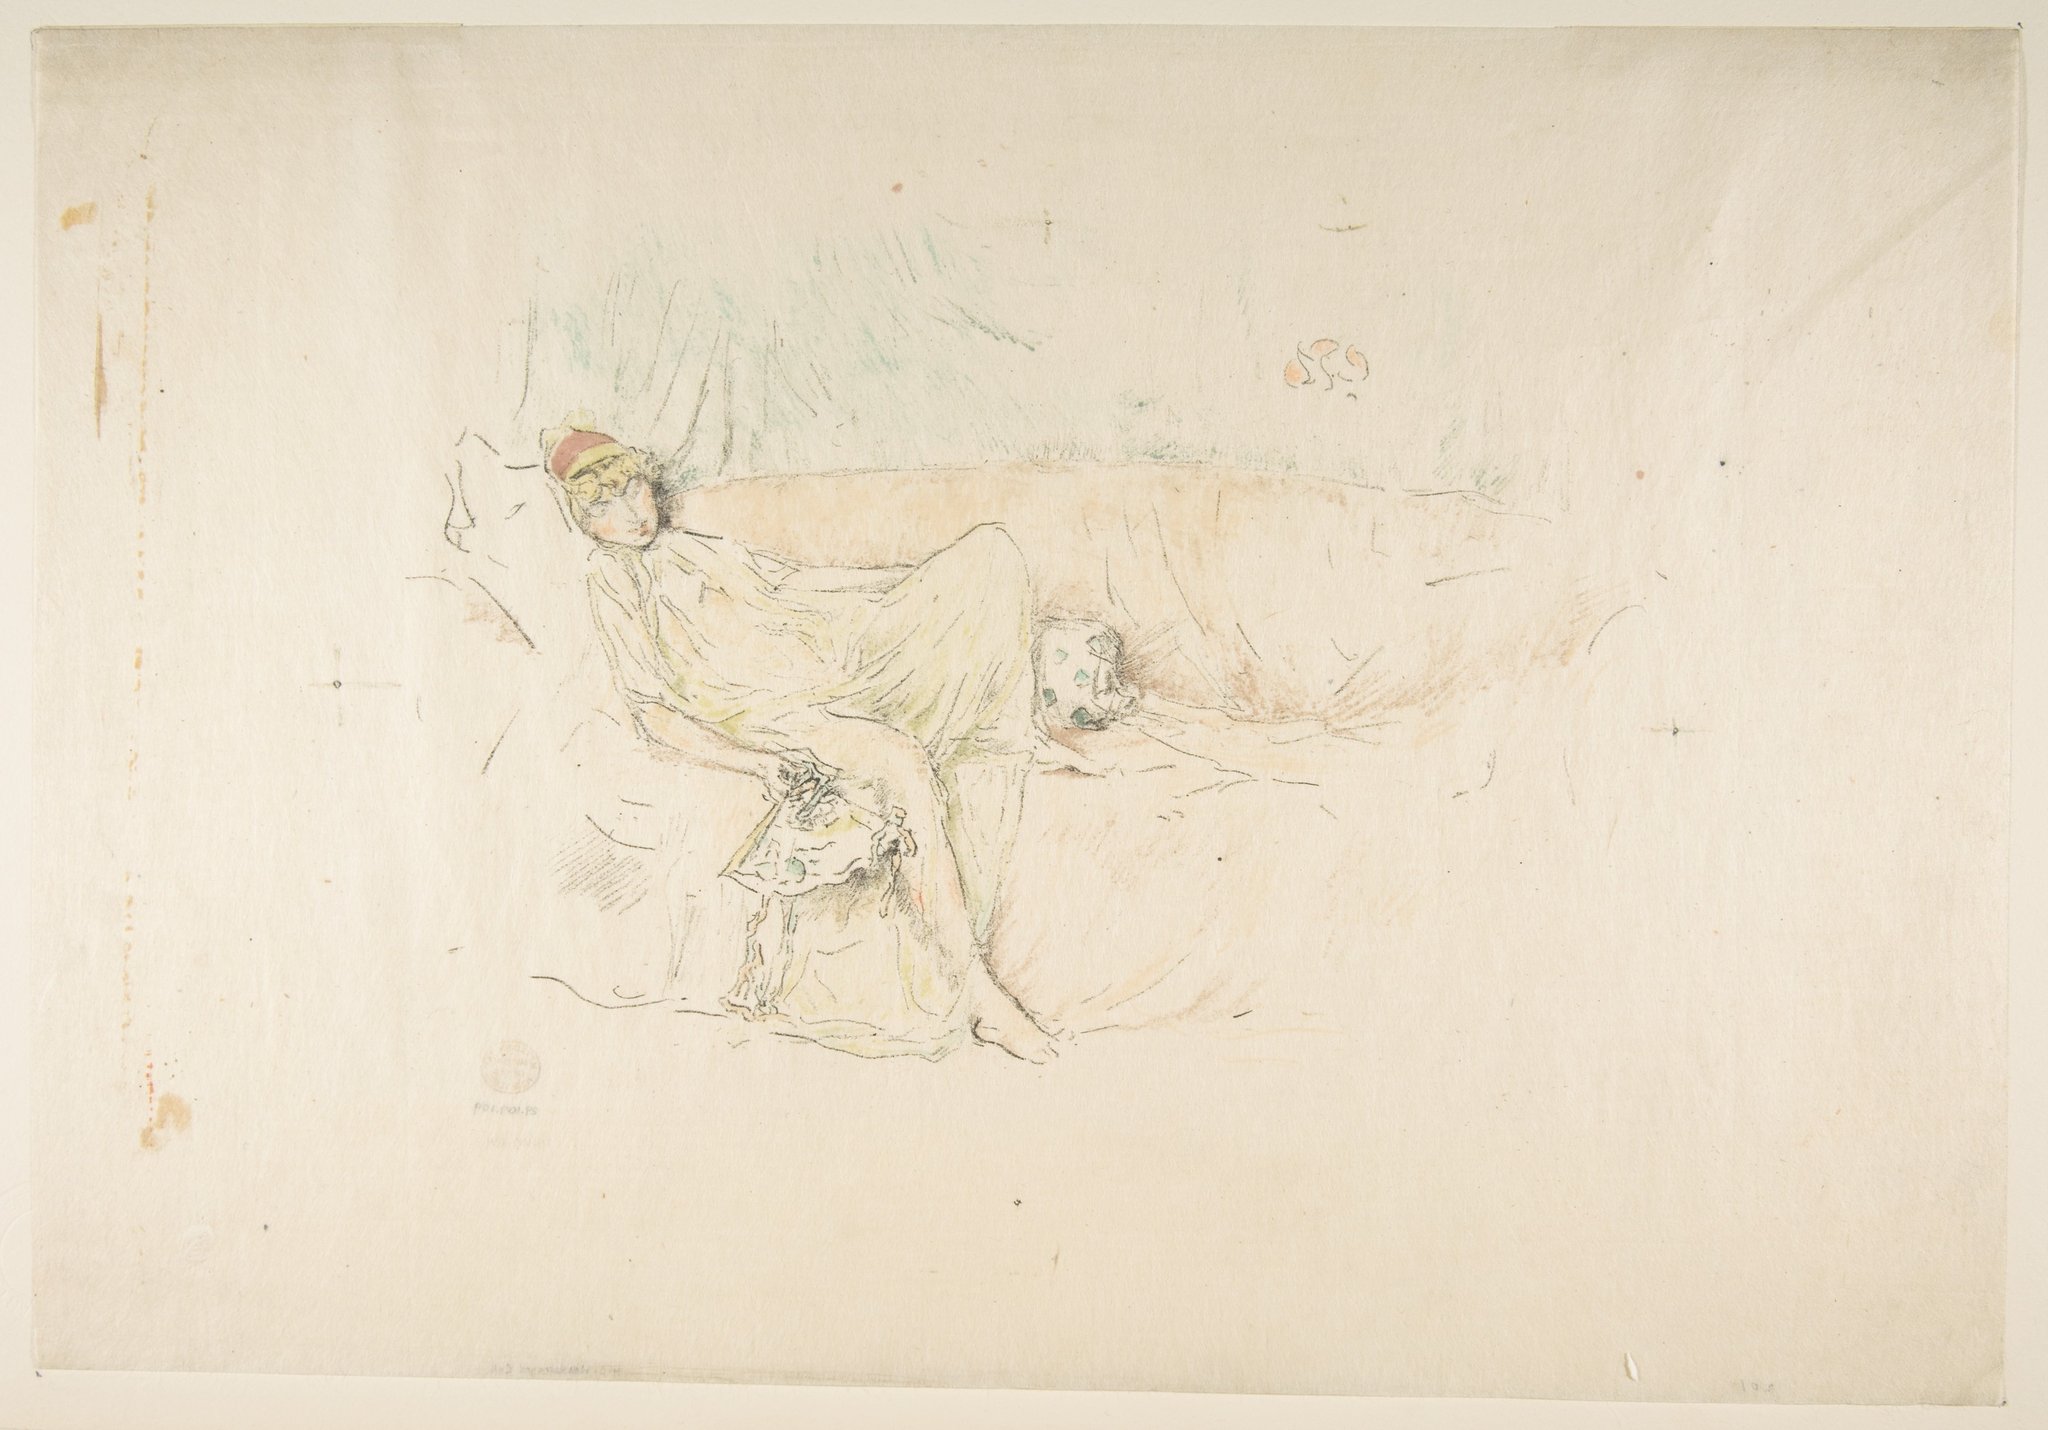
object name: print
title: Draped Figure Reclining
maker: james mcneill whistler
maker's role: artist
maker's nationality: american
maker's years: 1834-1903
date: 1892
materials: paper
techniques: printing, lithography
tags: human figures